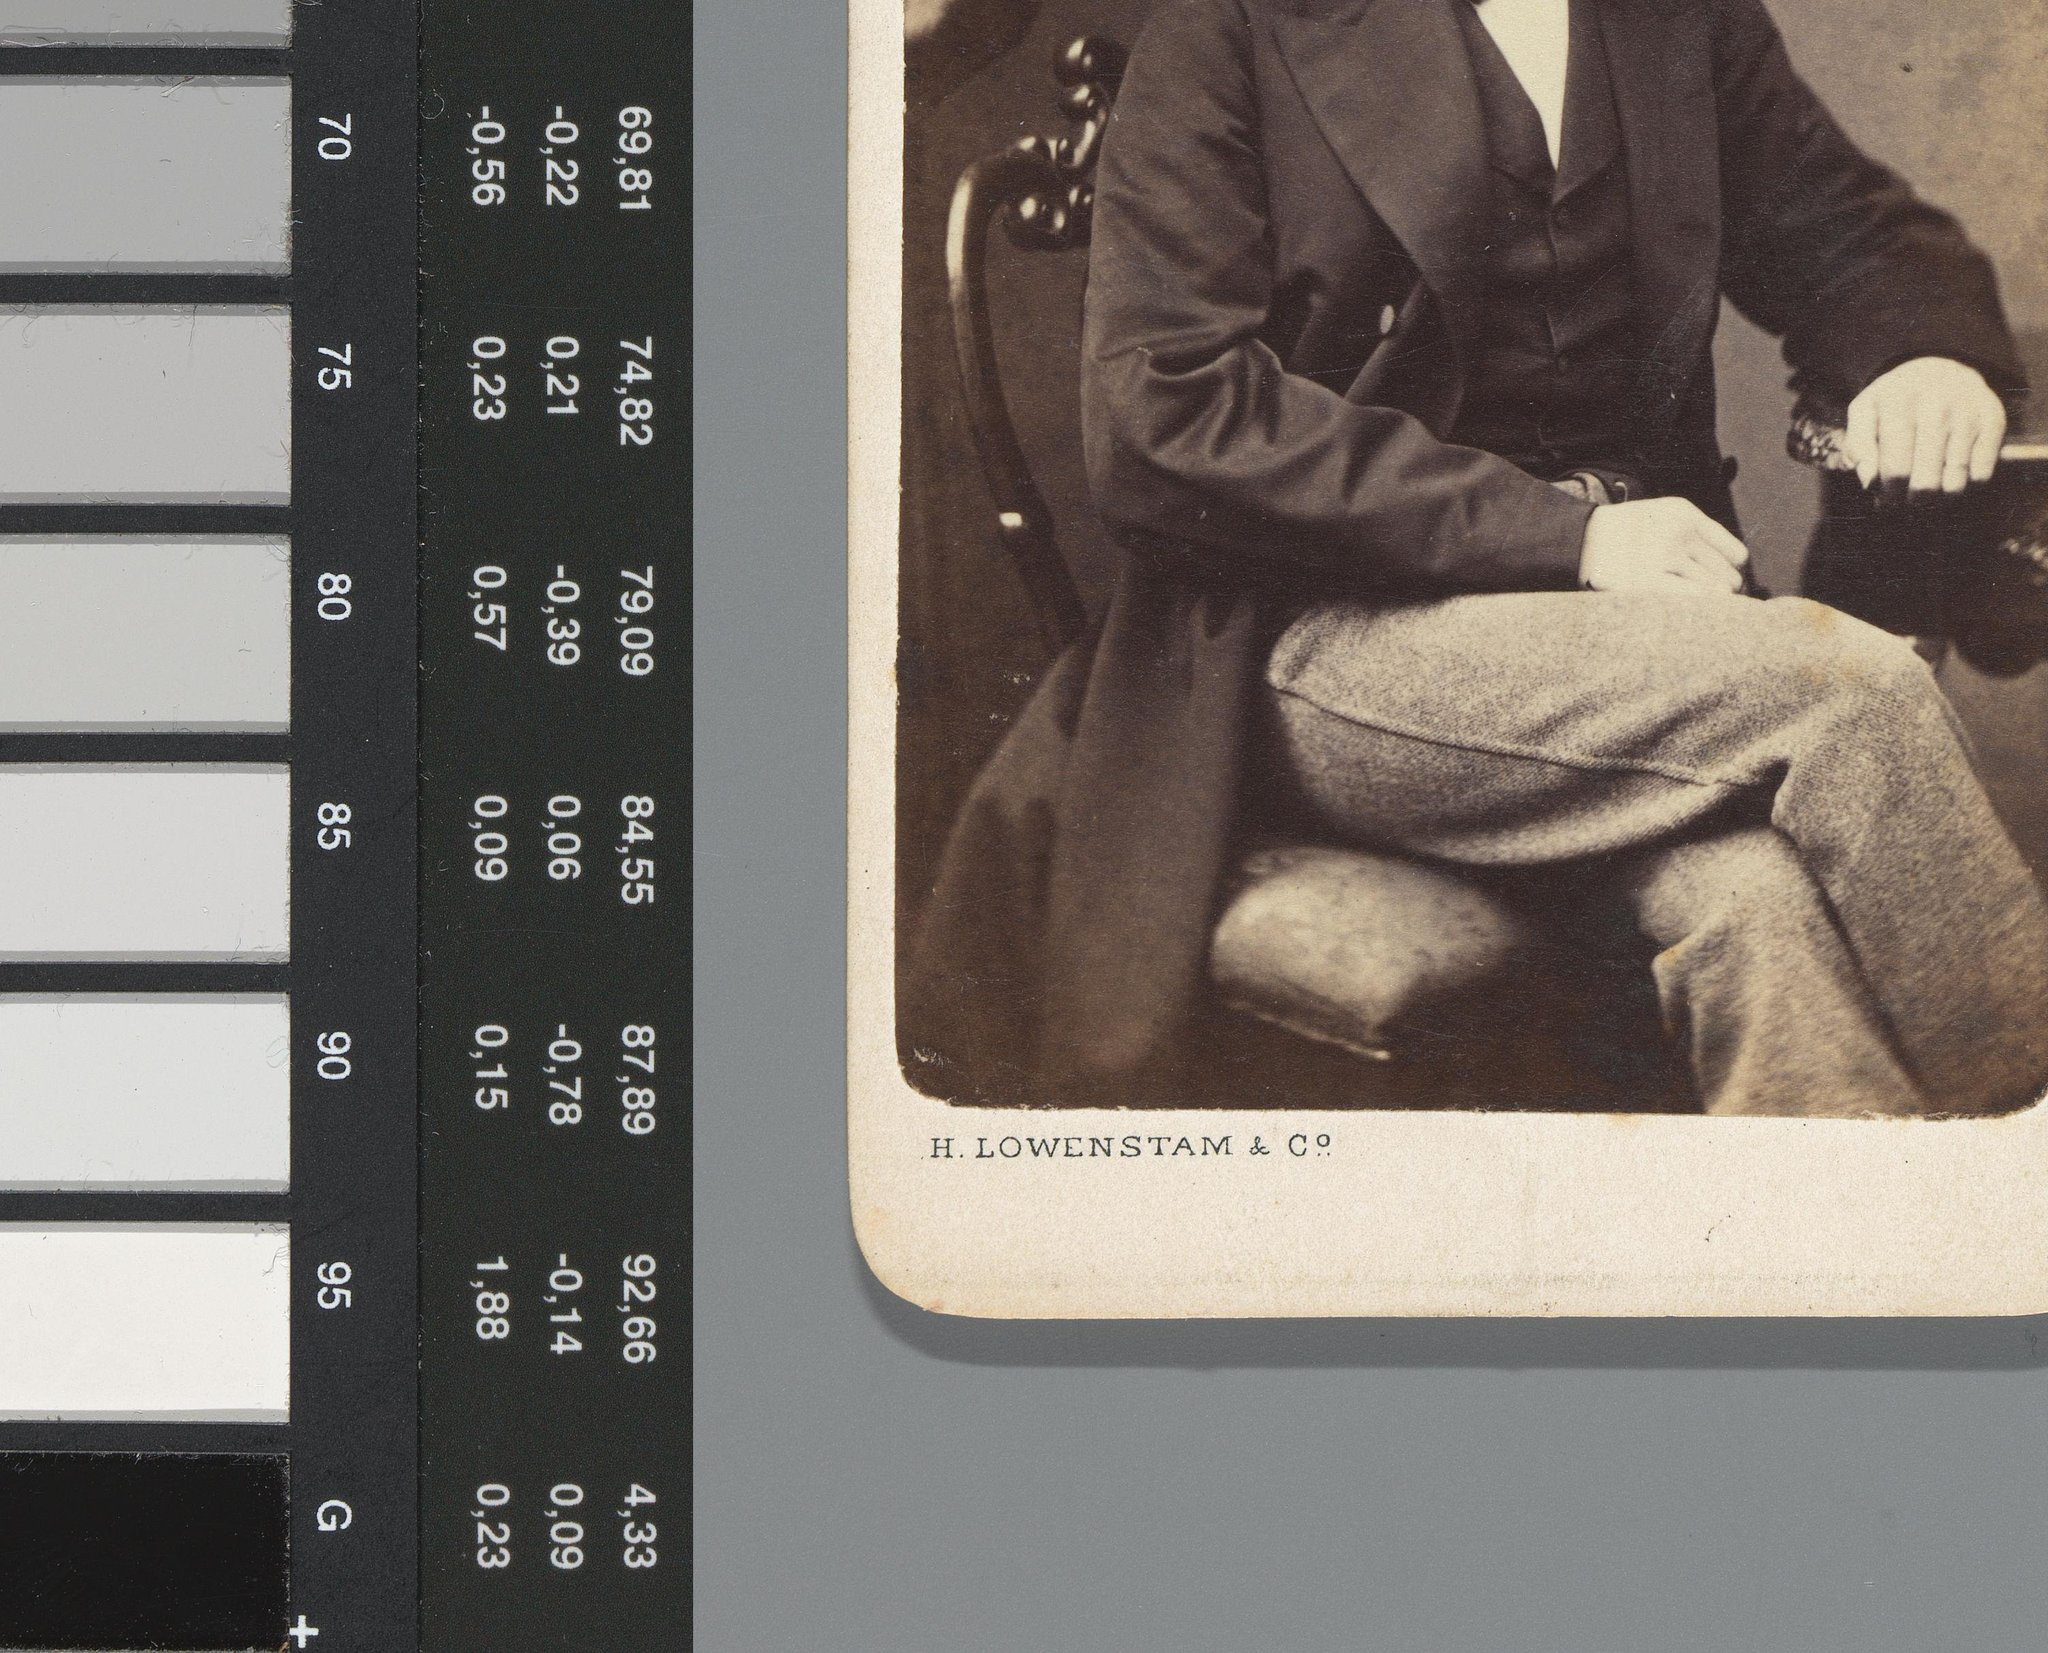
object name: carte de visite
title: Portret van Norbert van den Berg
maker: heinrich löwenstam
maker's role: painter, print maker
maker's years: 1815-1887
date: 1855-1910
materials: cardboard, photographic support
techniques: albumen print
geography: amsterdam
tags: rotterdam, amsterdam, norbertus petrus van den berg (1831-1917)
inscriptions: name: ‘H. LOWENSTAM & Co / Singel 454 / AMSTERDAM’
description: Portret van Norbert van den Berg zittend op een stoel met een arm leunend op een tafel.